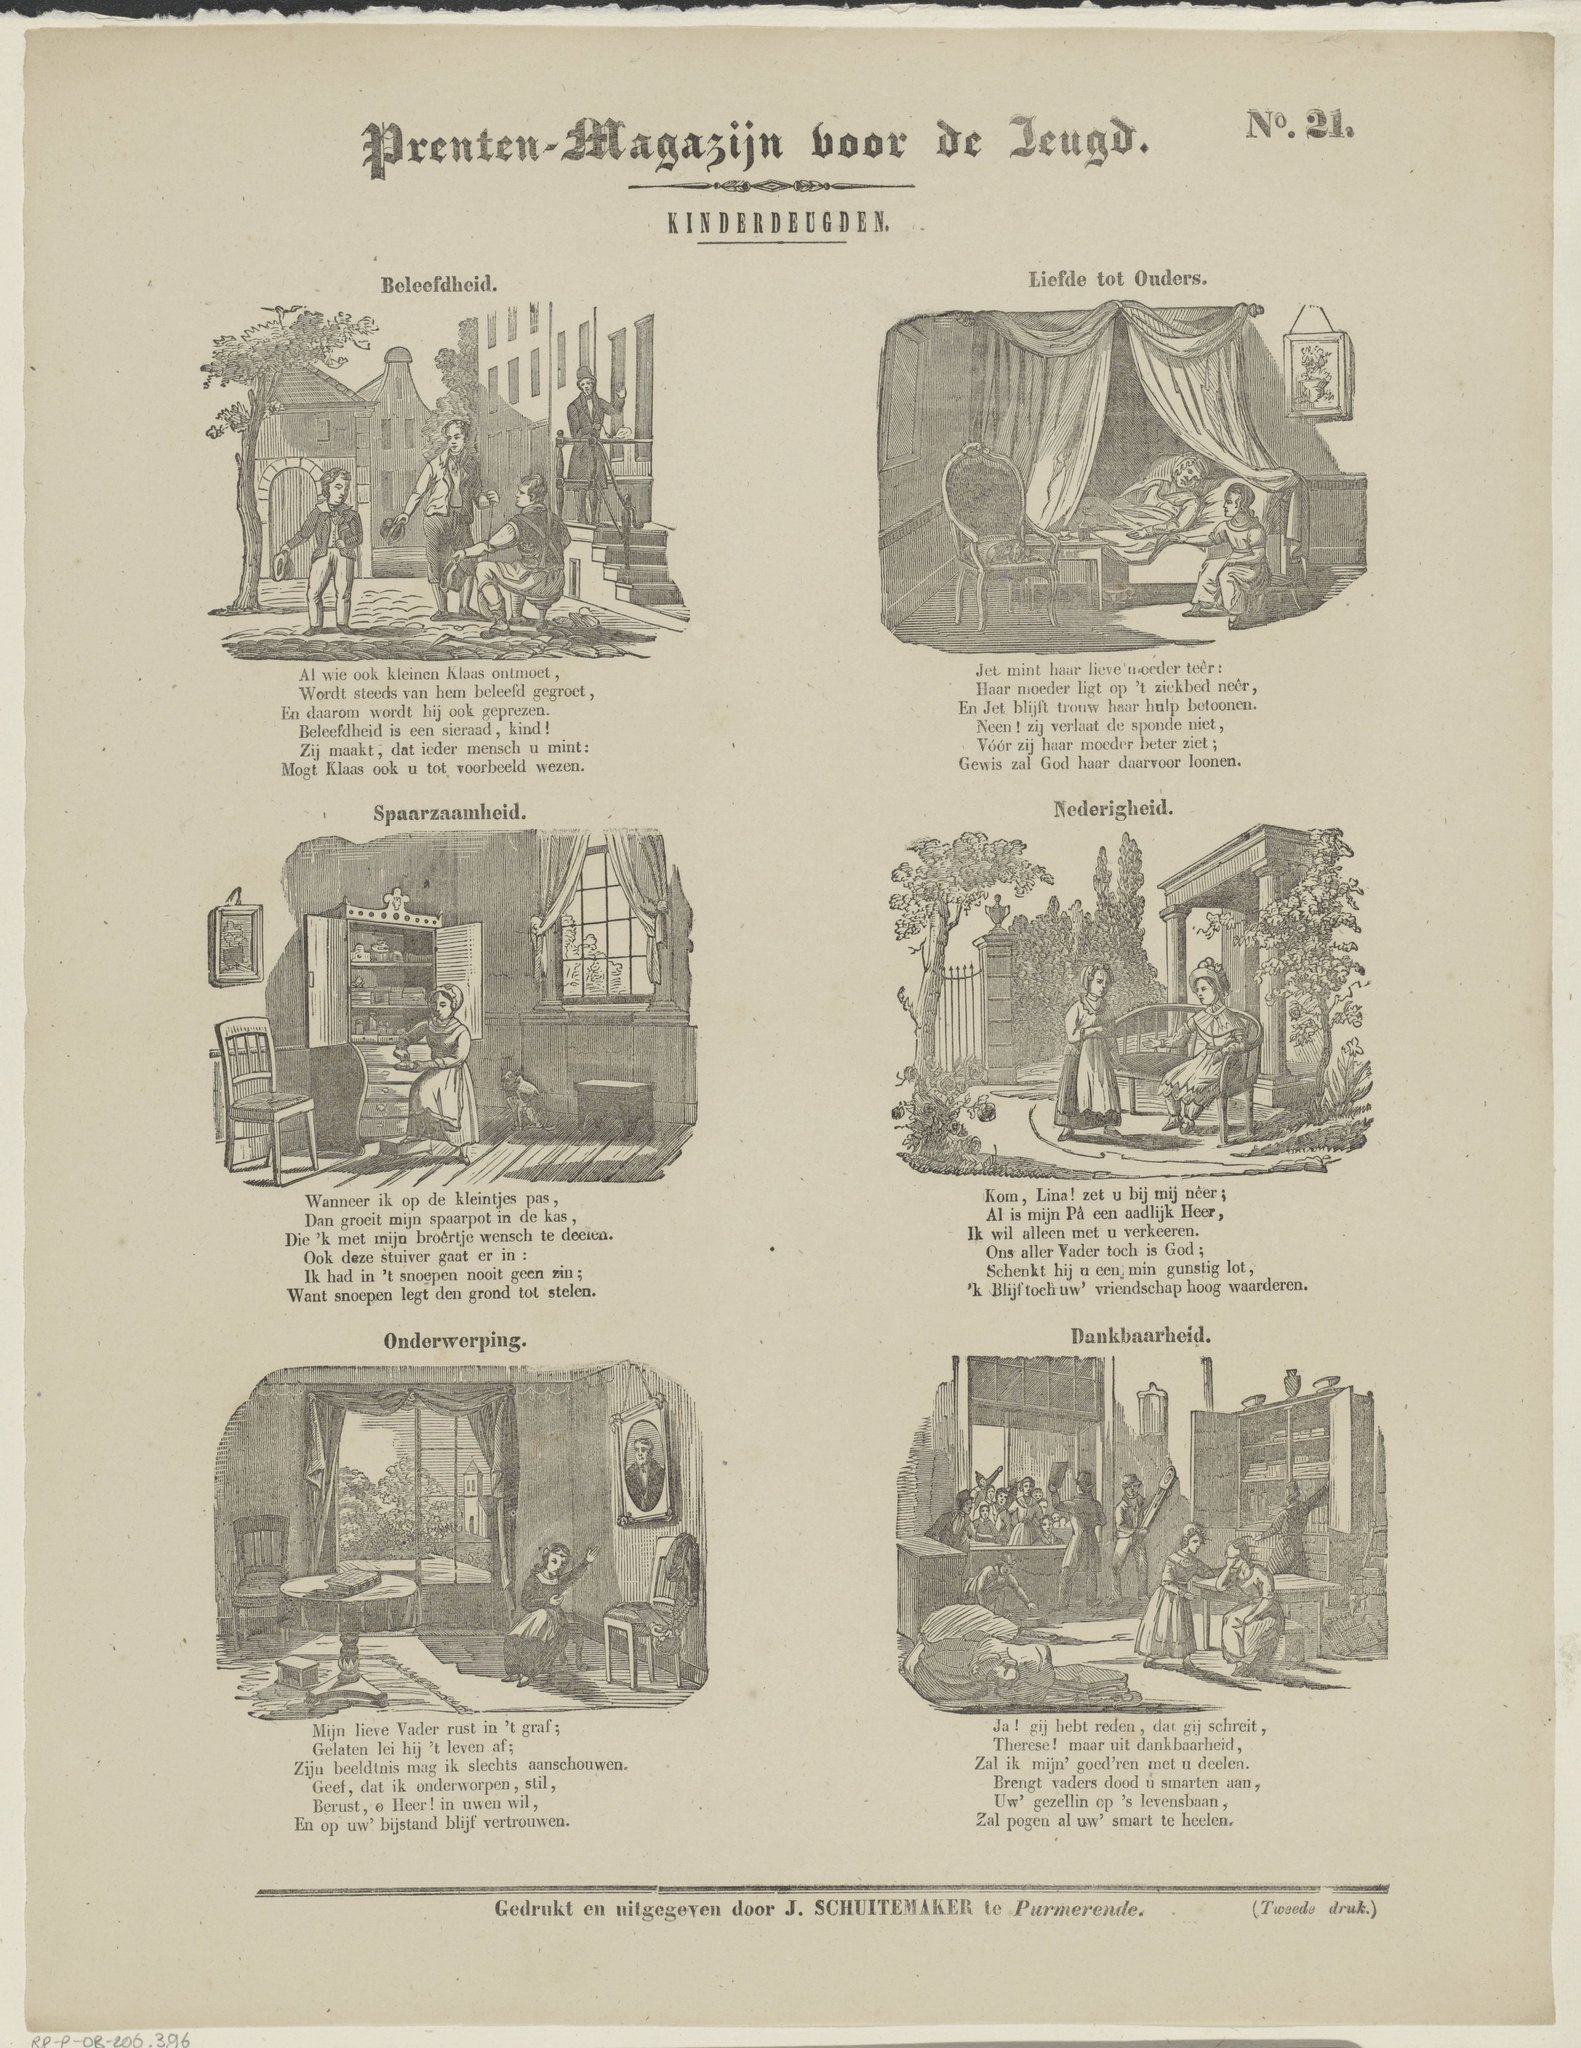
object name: popular print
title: Kinderdeugden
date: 1842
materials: paper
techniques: letterpress printing, engraving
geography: purmerend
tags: parents with their children, humanity, politeness; 'cortesia', 'humanità' (ripa), submissiveness; 'ossequio' (ripa), saving, frugality, parsimony; 'parsimonia' (ripa), gratitude; 'gratitudine', 'memoria grata de beneficii ricevuti' (ripa), humility; 'humiltà' (ripa)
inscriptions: collector's mark: Lugt 2760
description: Blad met 6 voorstellingen van kinderdeugden, zoals beleefdheid, spaarzaamheid en nederigheid. Boven elke voorstelling een titel en onder elke voorstelling een zesregelig vers. Genummerd rechtsboven: No. 21